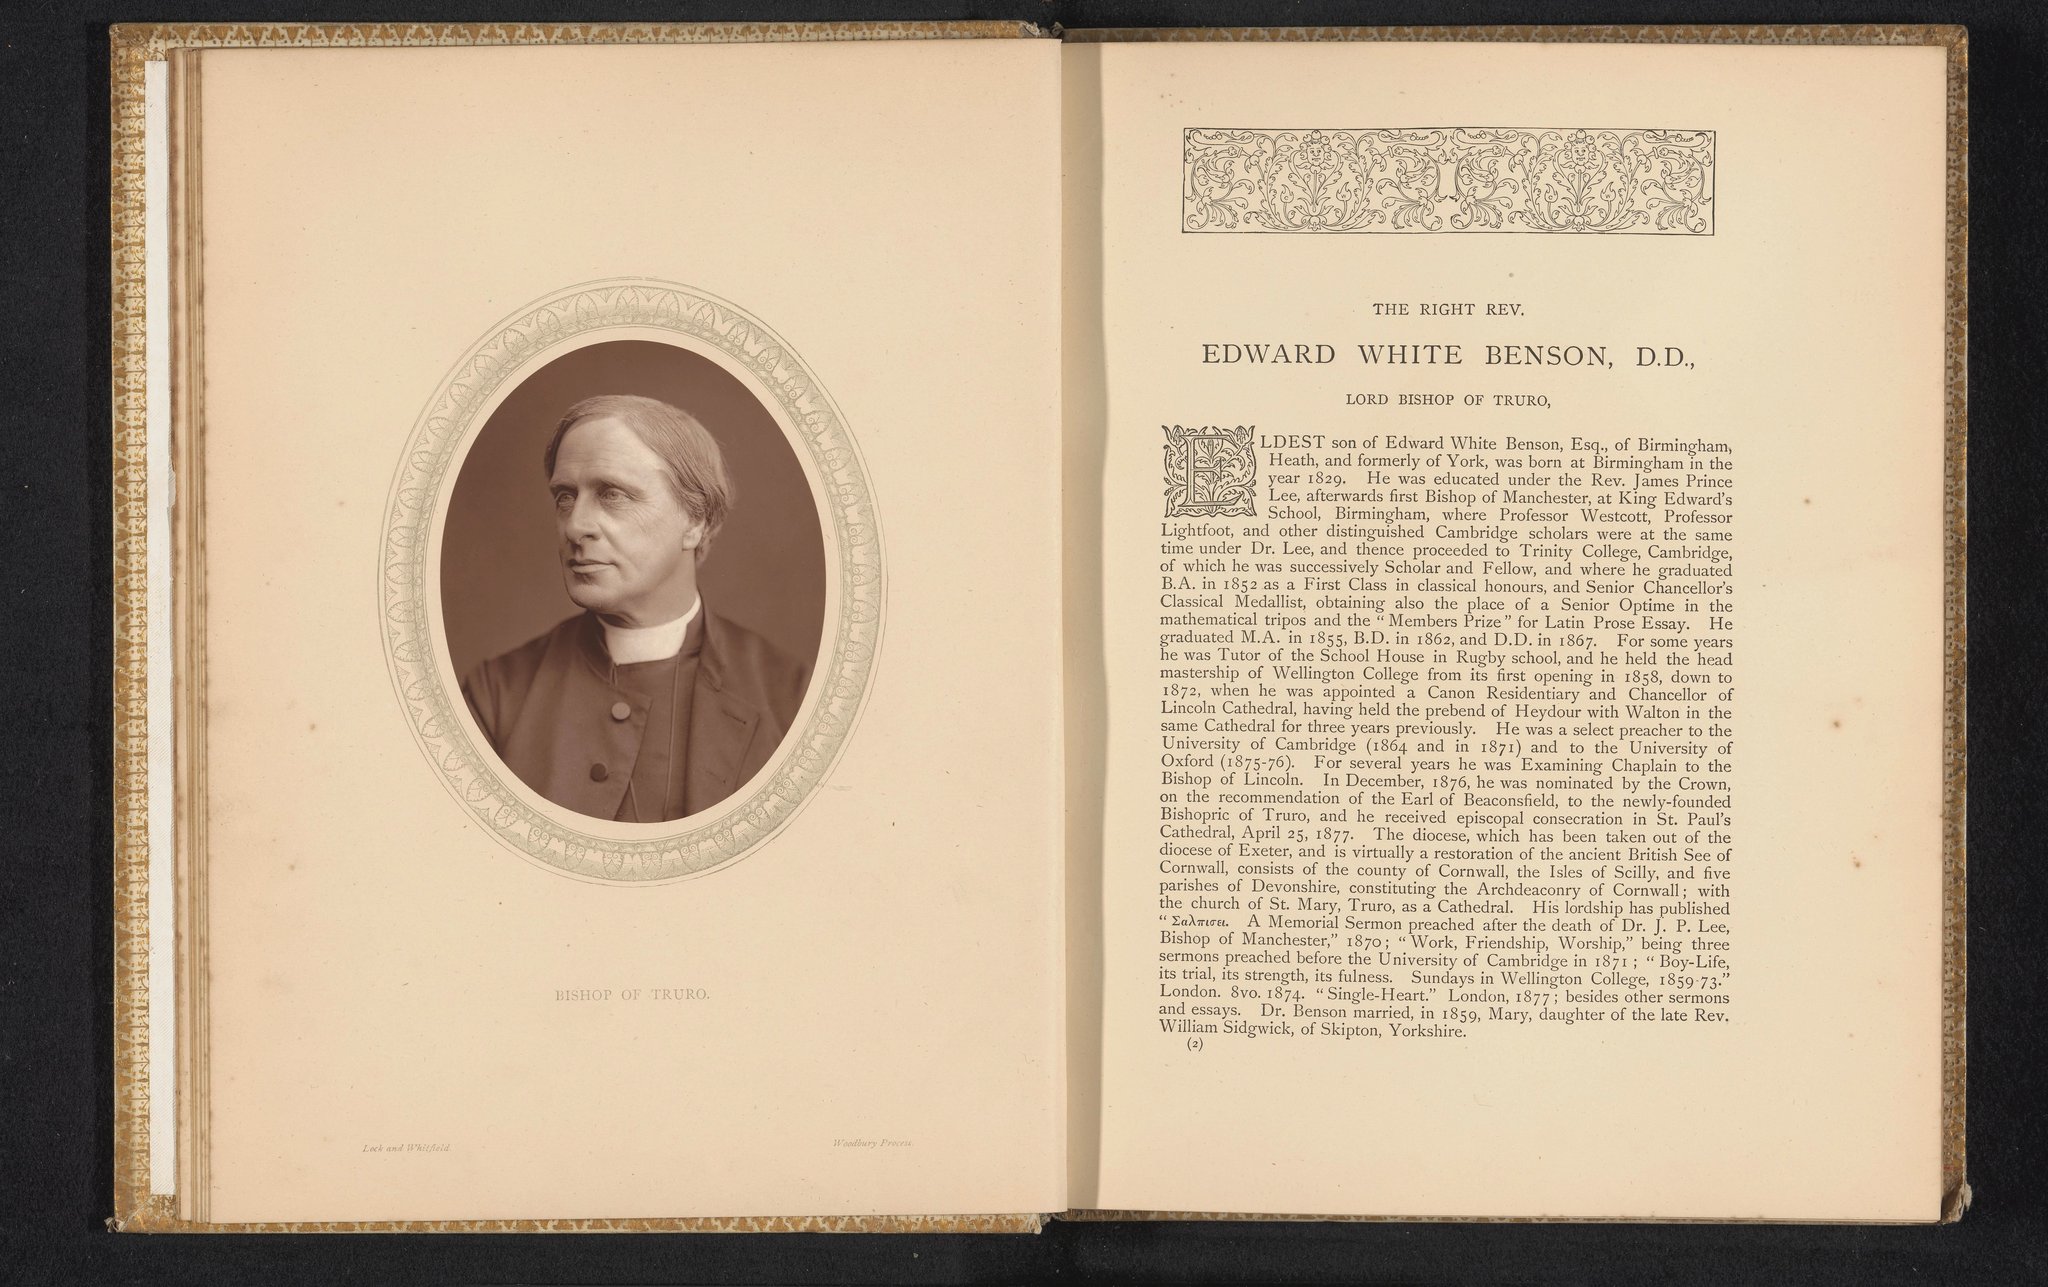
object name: page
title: Bishop of Truro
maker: Anonymous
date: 1875-1880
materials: paper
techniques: woodburytype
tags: archbishop, bishop, etc. (roman catholic), historical persons (portraits and scenes from the life) (+ (full) bust portrait)